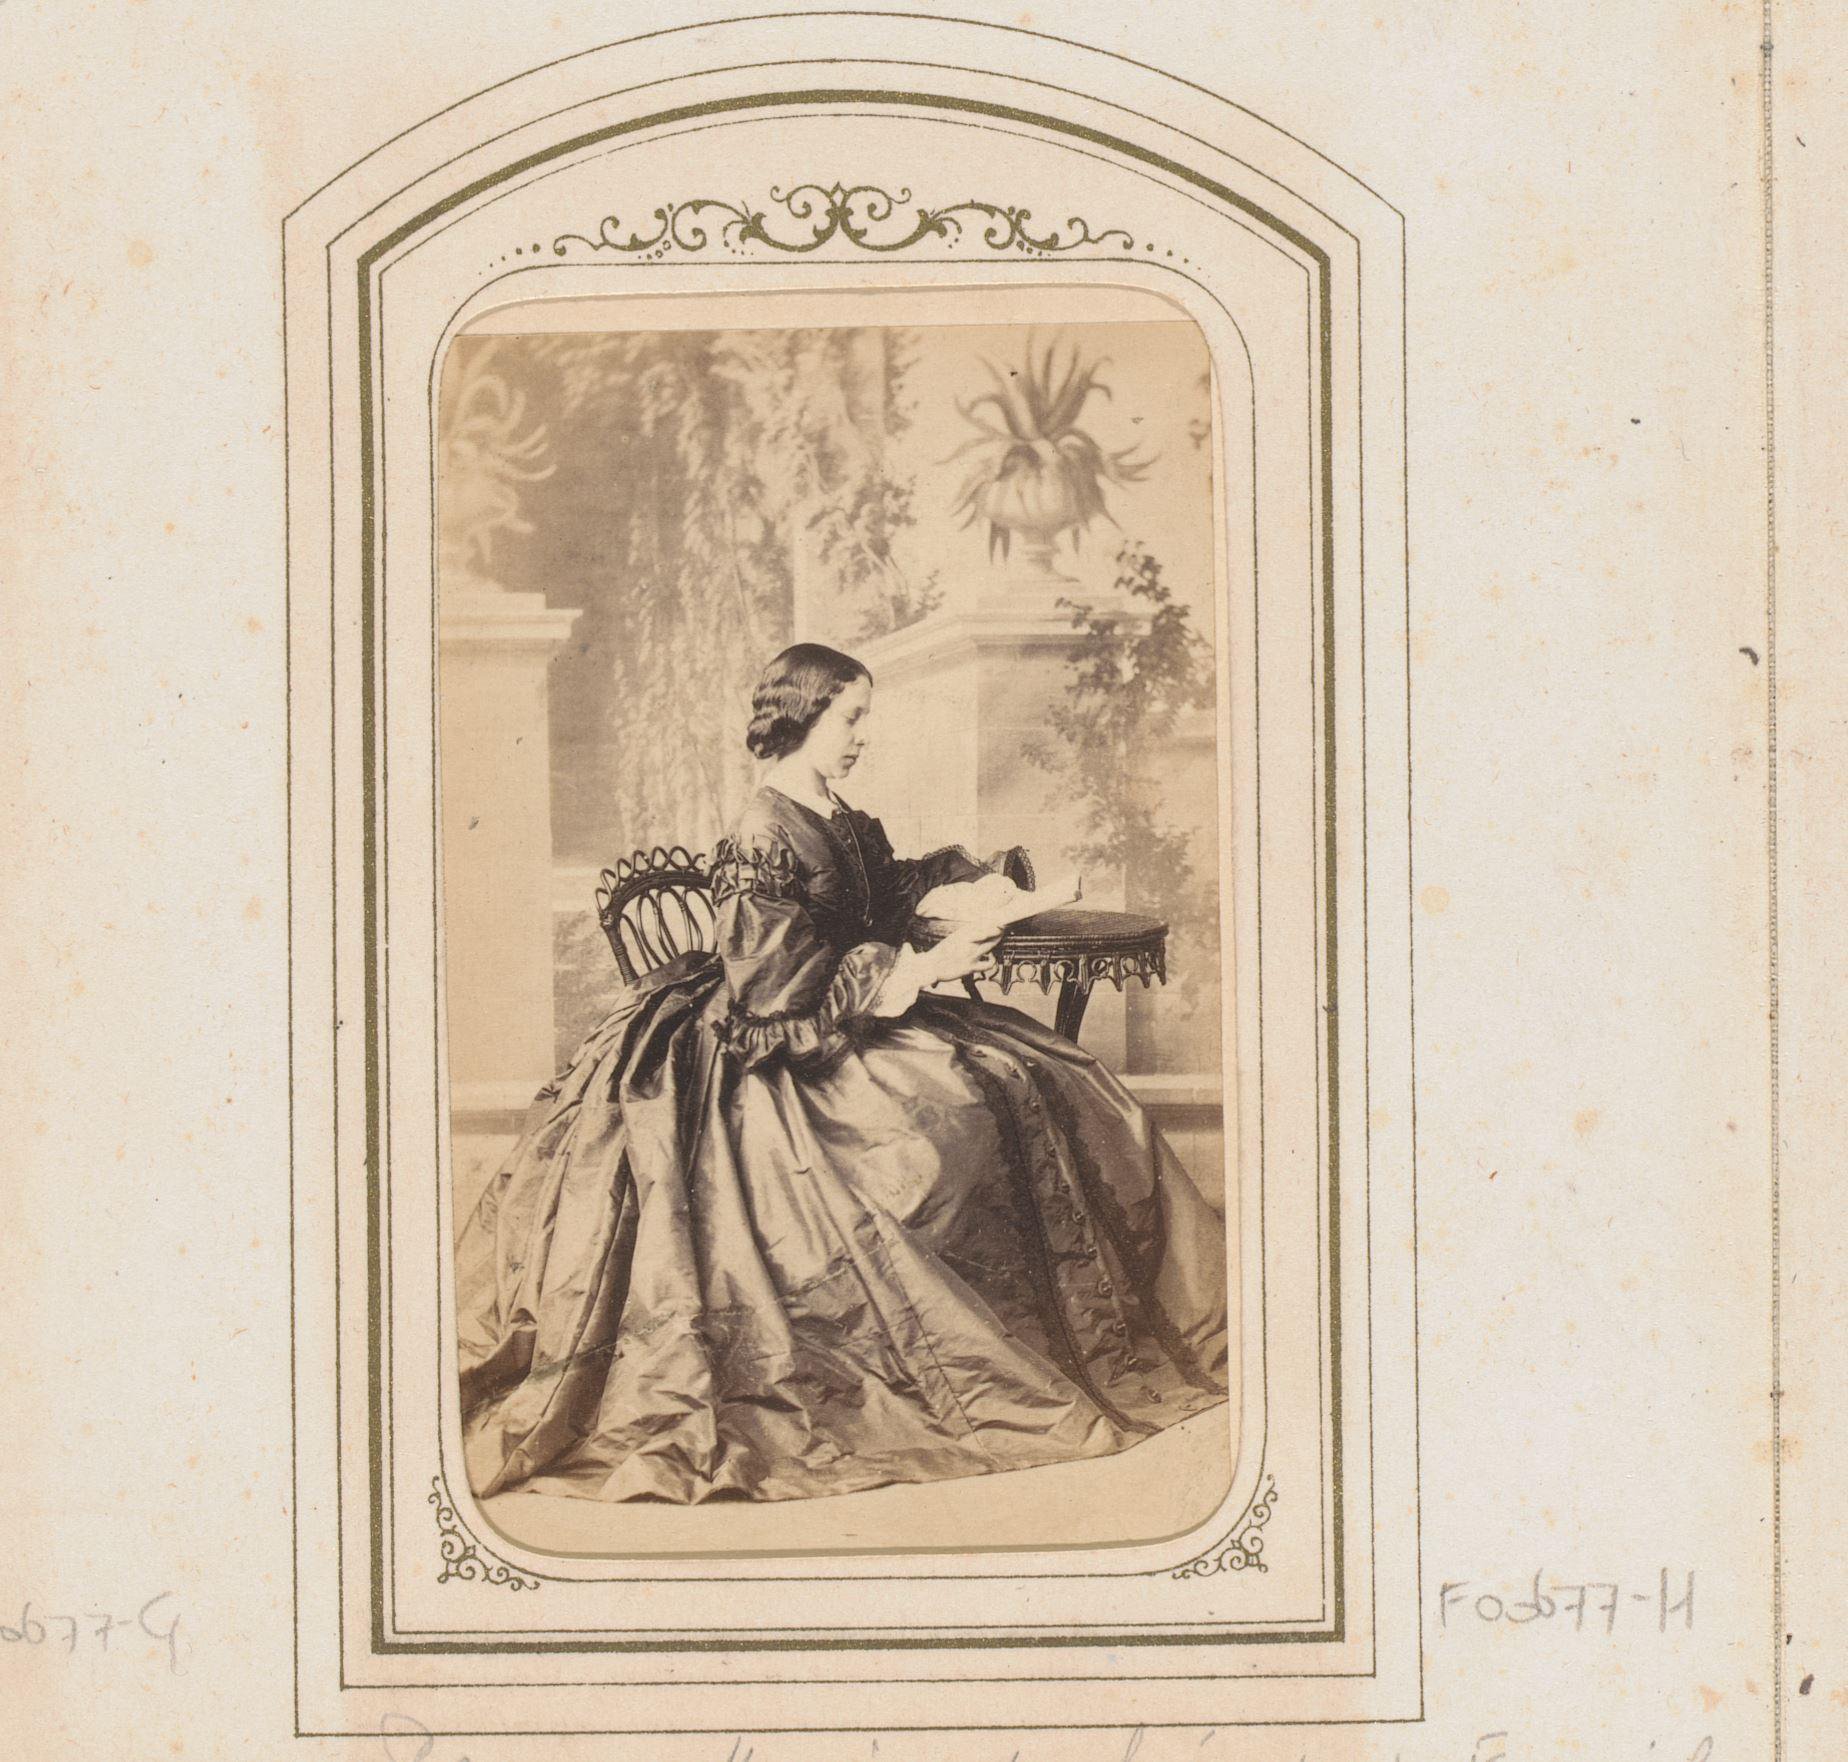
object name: carte de visite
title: Portret van Marie van Oranje-Nassau, prinses der Nederlanden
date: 1855-1870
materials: cardboard, photographic support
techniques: albumen print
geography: germany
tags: historical persons - bb - woman, princess, germany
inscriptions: annotation: ‘Prinses Marie, dochter prins Frederik/ 1841- Fürstin zu Wied’, inscription: ‘L. Haase & Comp. in Berlin,/ Königl. Hof-Photographen/ und Hof-Photographen Ihrer Kgl. Hoheit der Frau/ Kronprinzessin v. Preussen./ 178. Grosse Friedrich-Strasse 178./ Breslau/ 10. Tauensienstr. 10.’